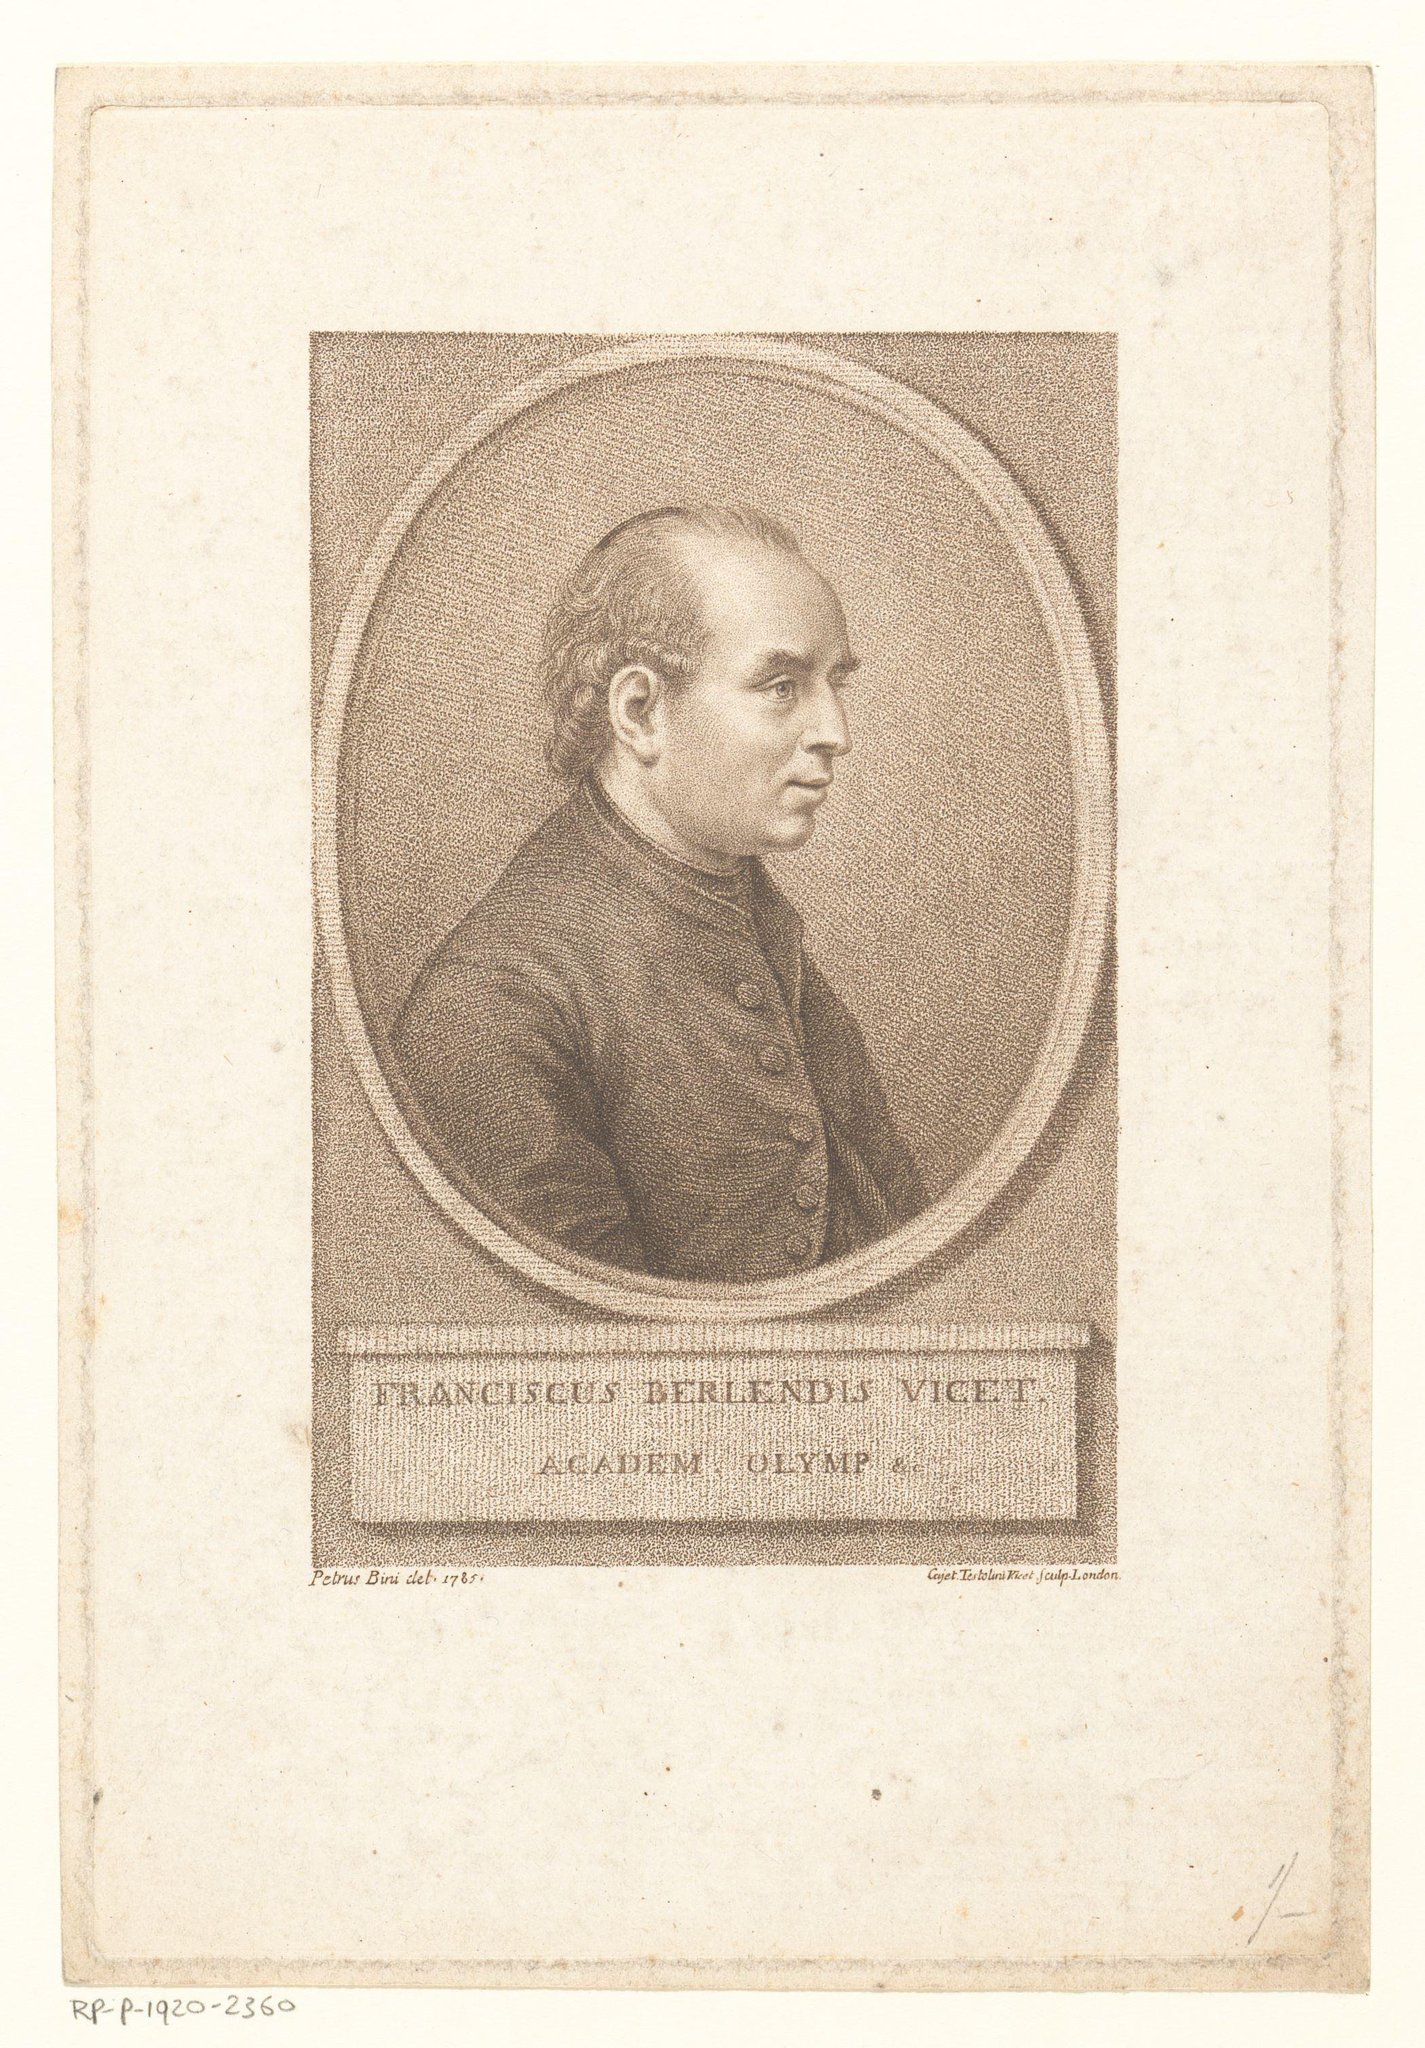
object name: print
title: Portret van Frederik Willem II, koning van Pruisen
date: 1759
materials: paper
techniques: engraving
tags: berlin, frederik willem ii (koning van pruisen), historical persons, ruler, sovereign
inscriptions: collector's mark: Lugt 2228